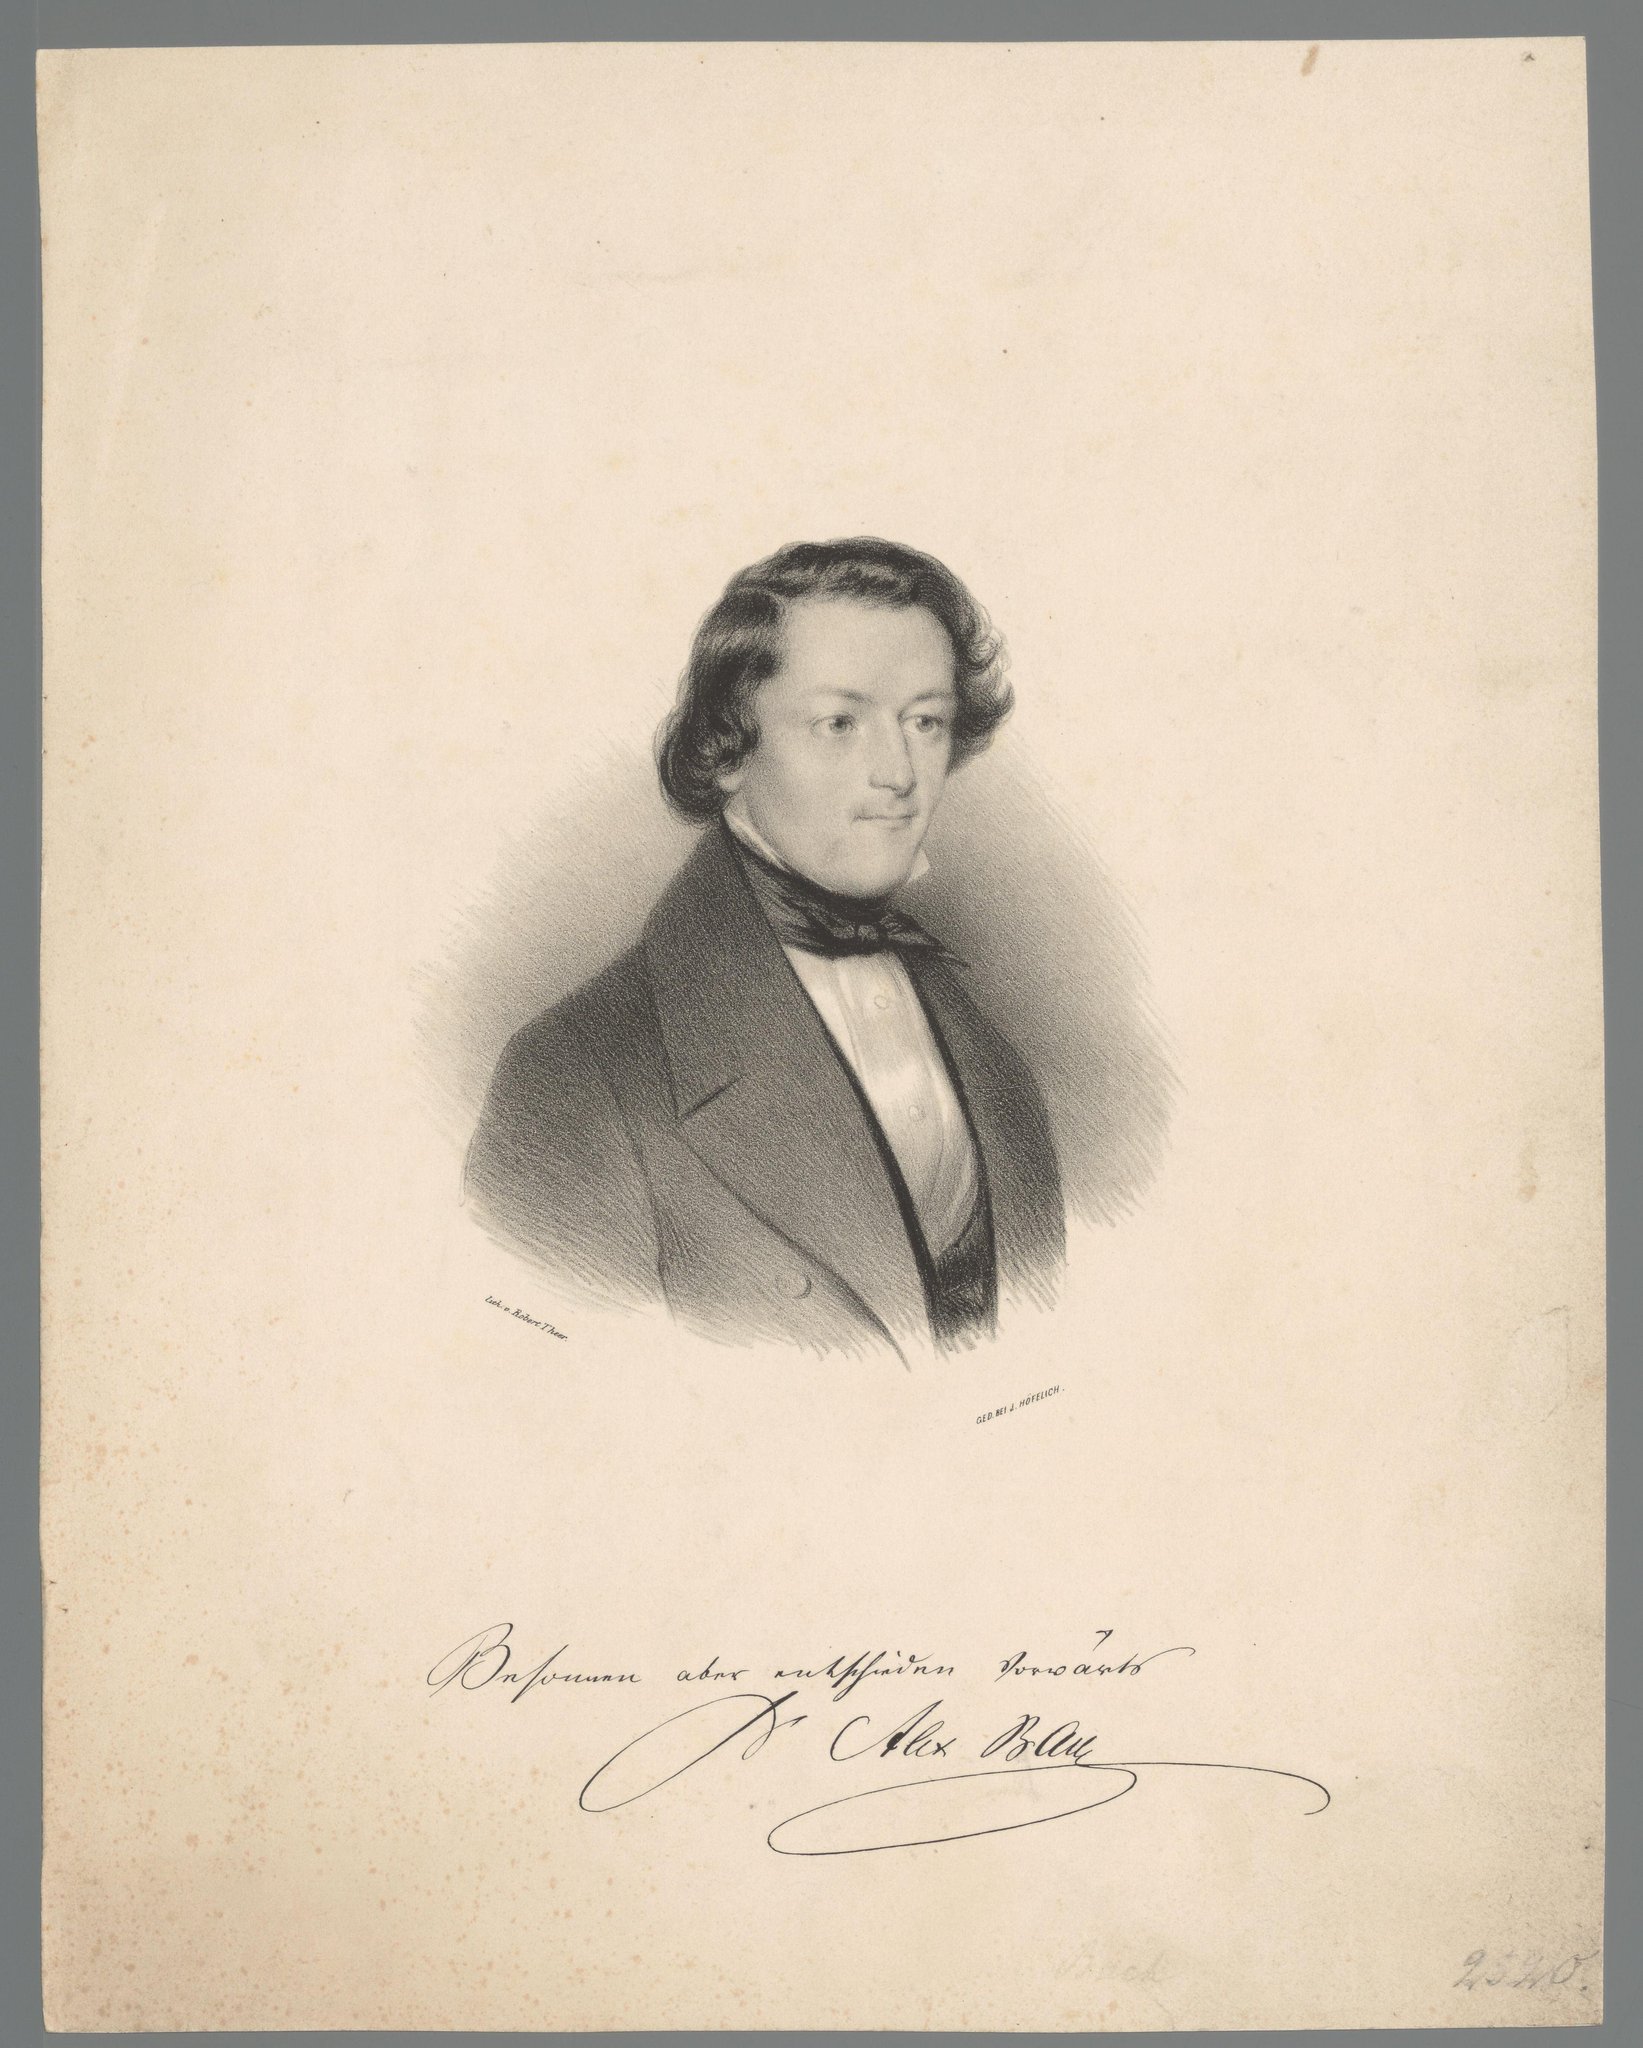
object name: print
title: Portret van een onbekende man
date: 1818-1863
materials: paper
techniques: lithograph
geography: vienna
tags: adult man, historical persons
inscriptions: collector's mark: Lugt 2228